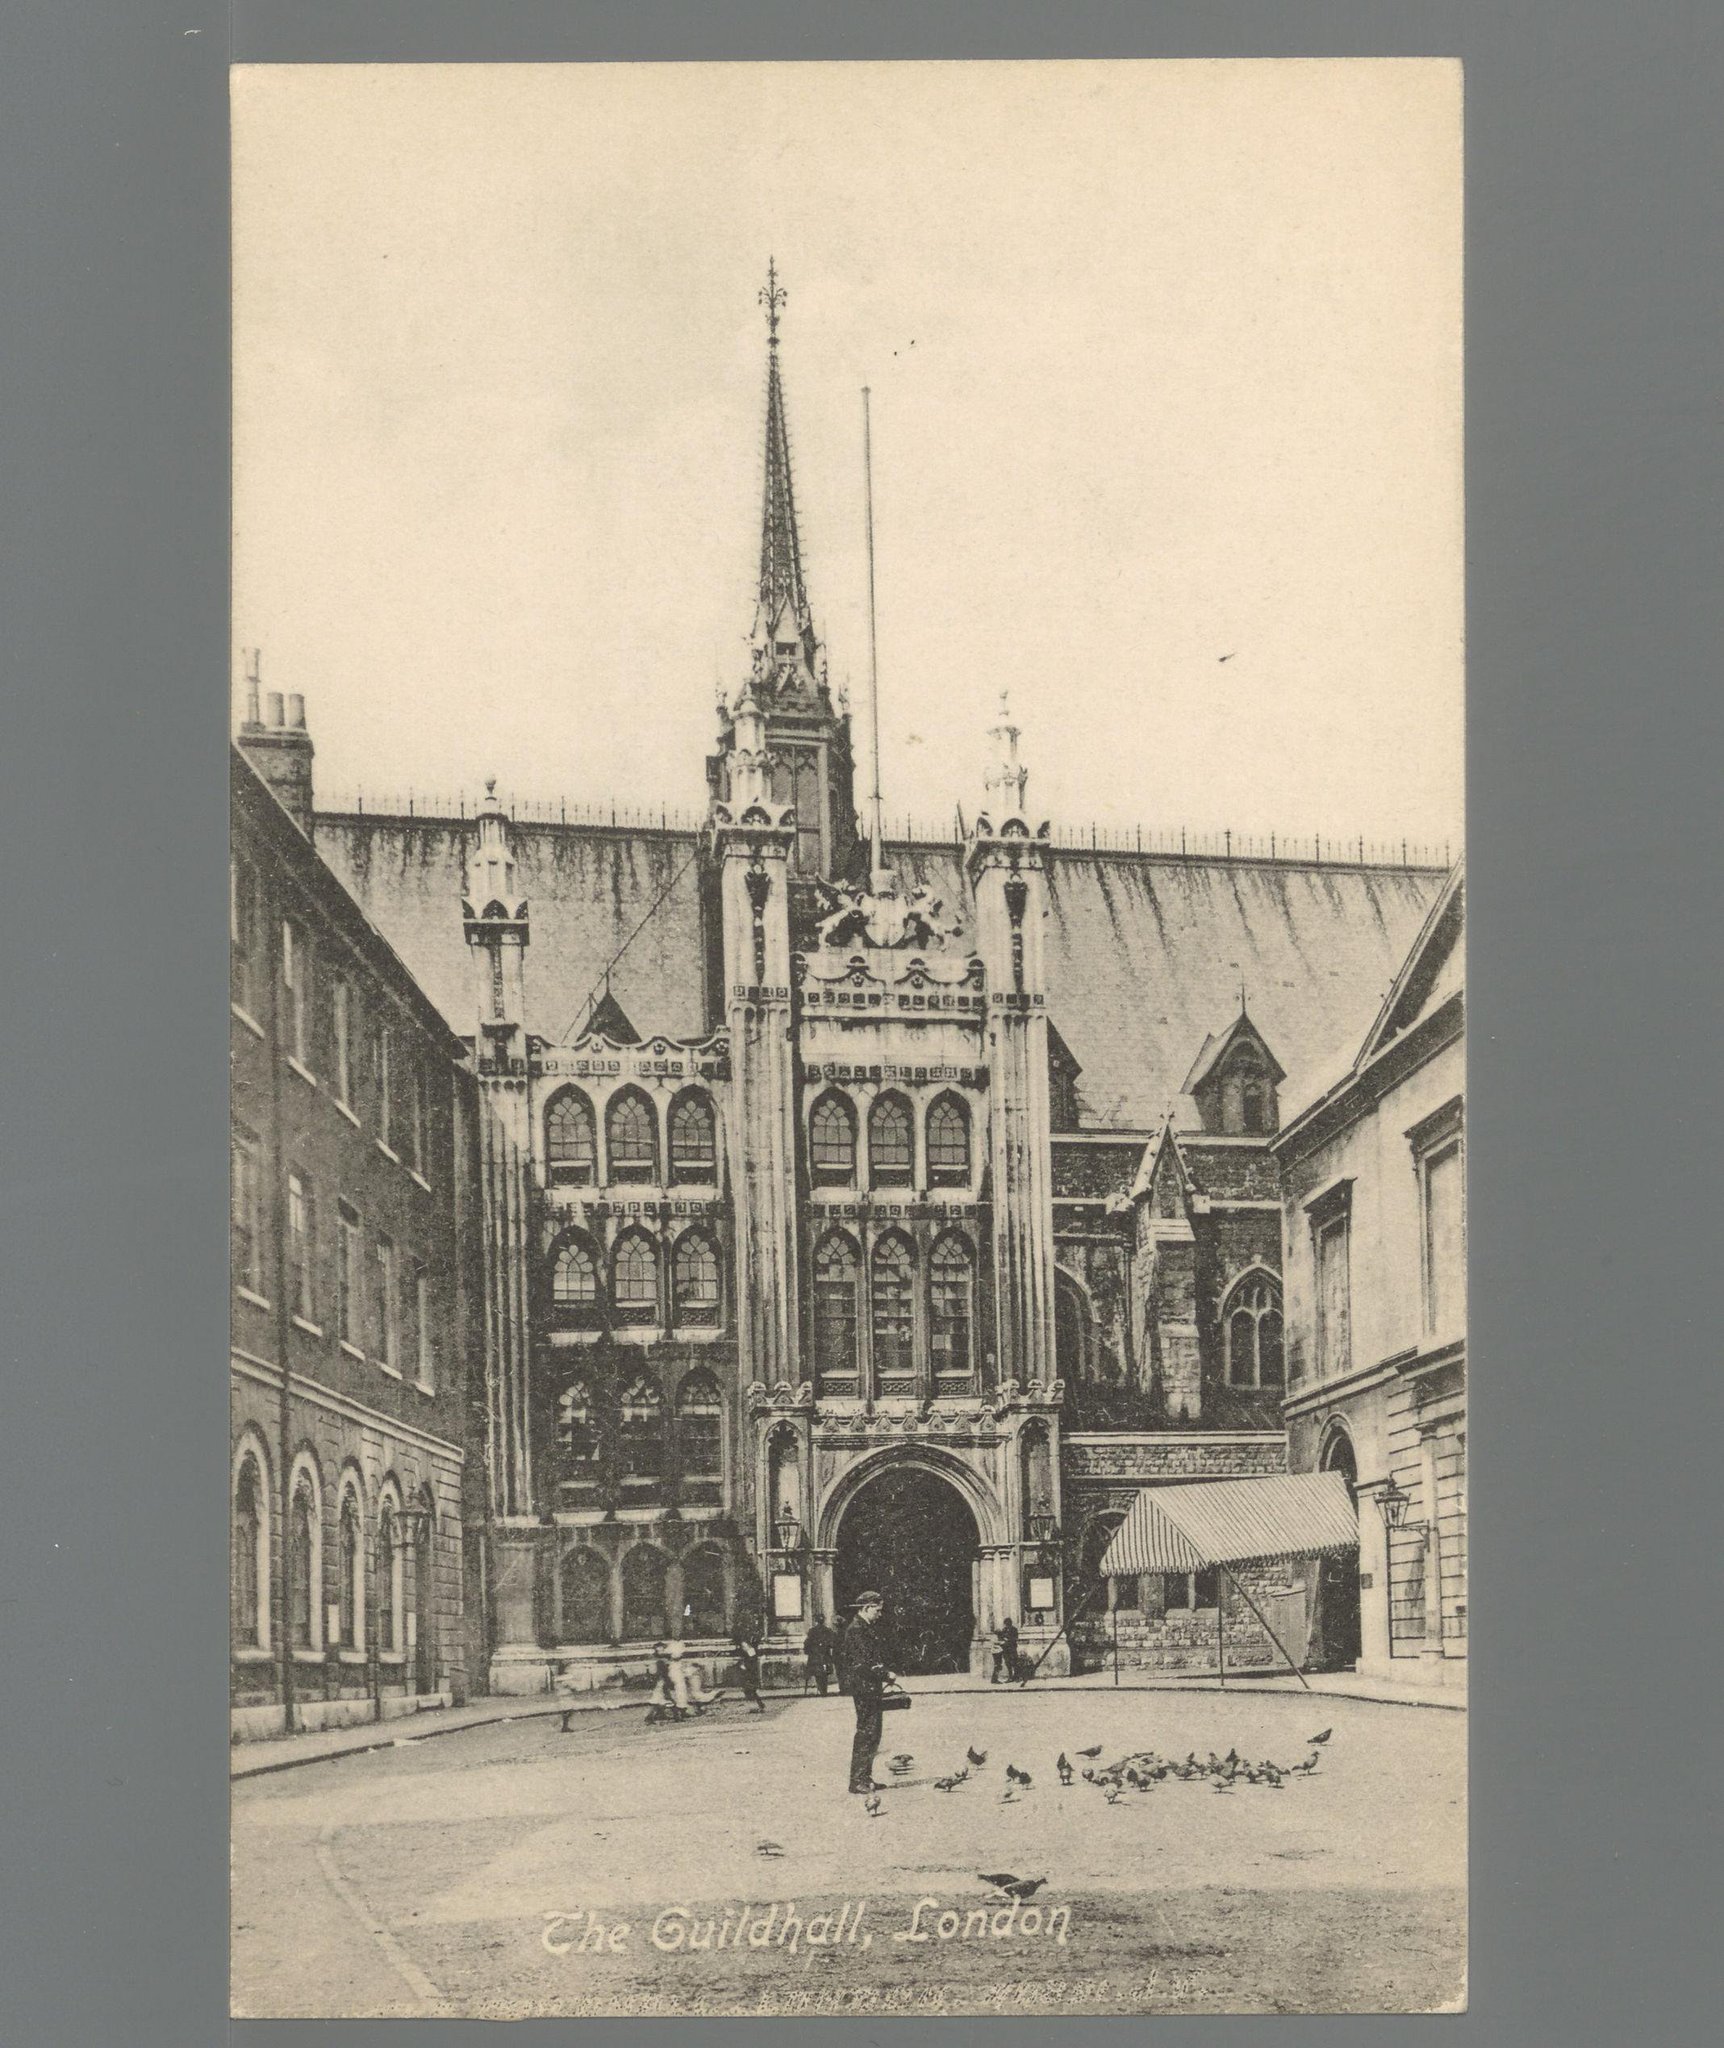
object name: photomechanical print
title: The Guildhall, London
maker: Anonymous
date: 1902-1930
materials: cardboard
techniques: photograph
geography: london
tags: townhall